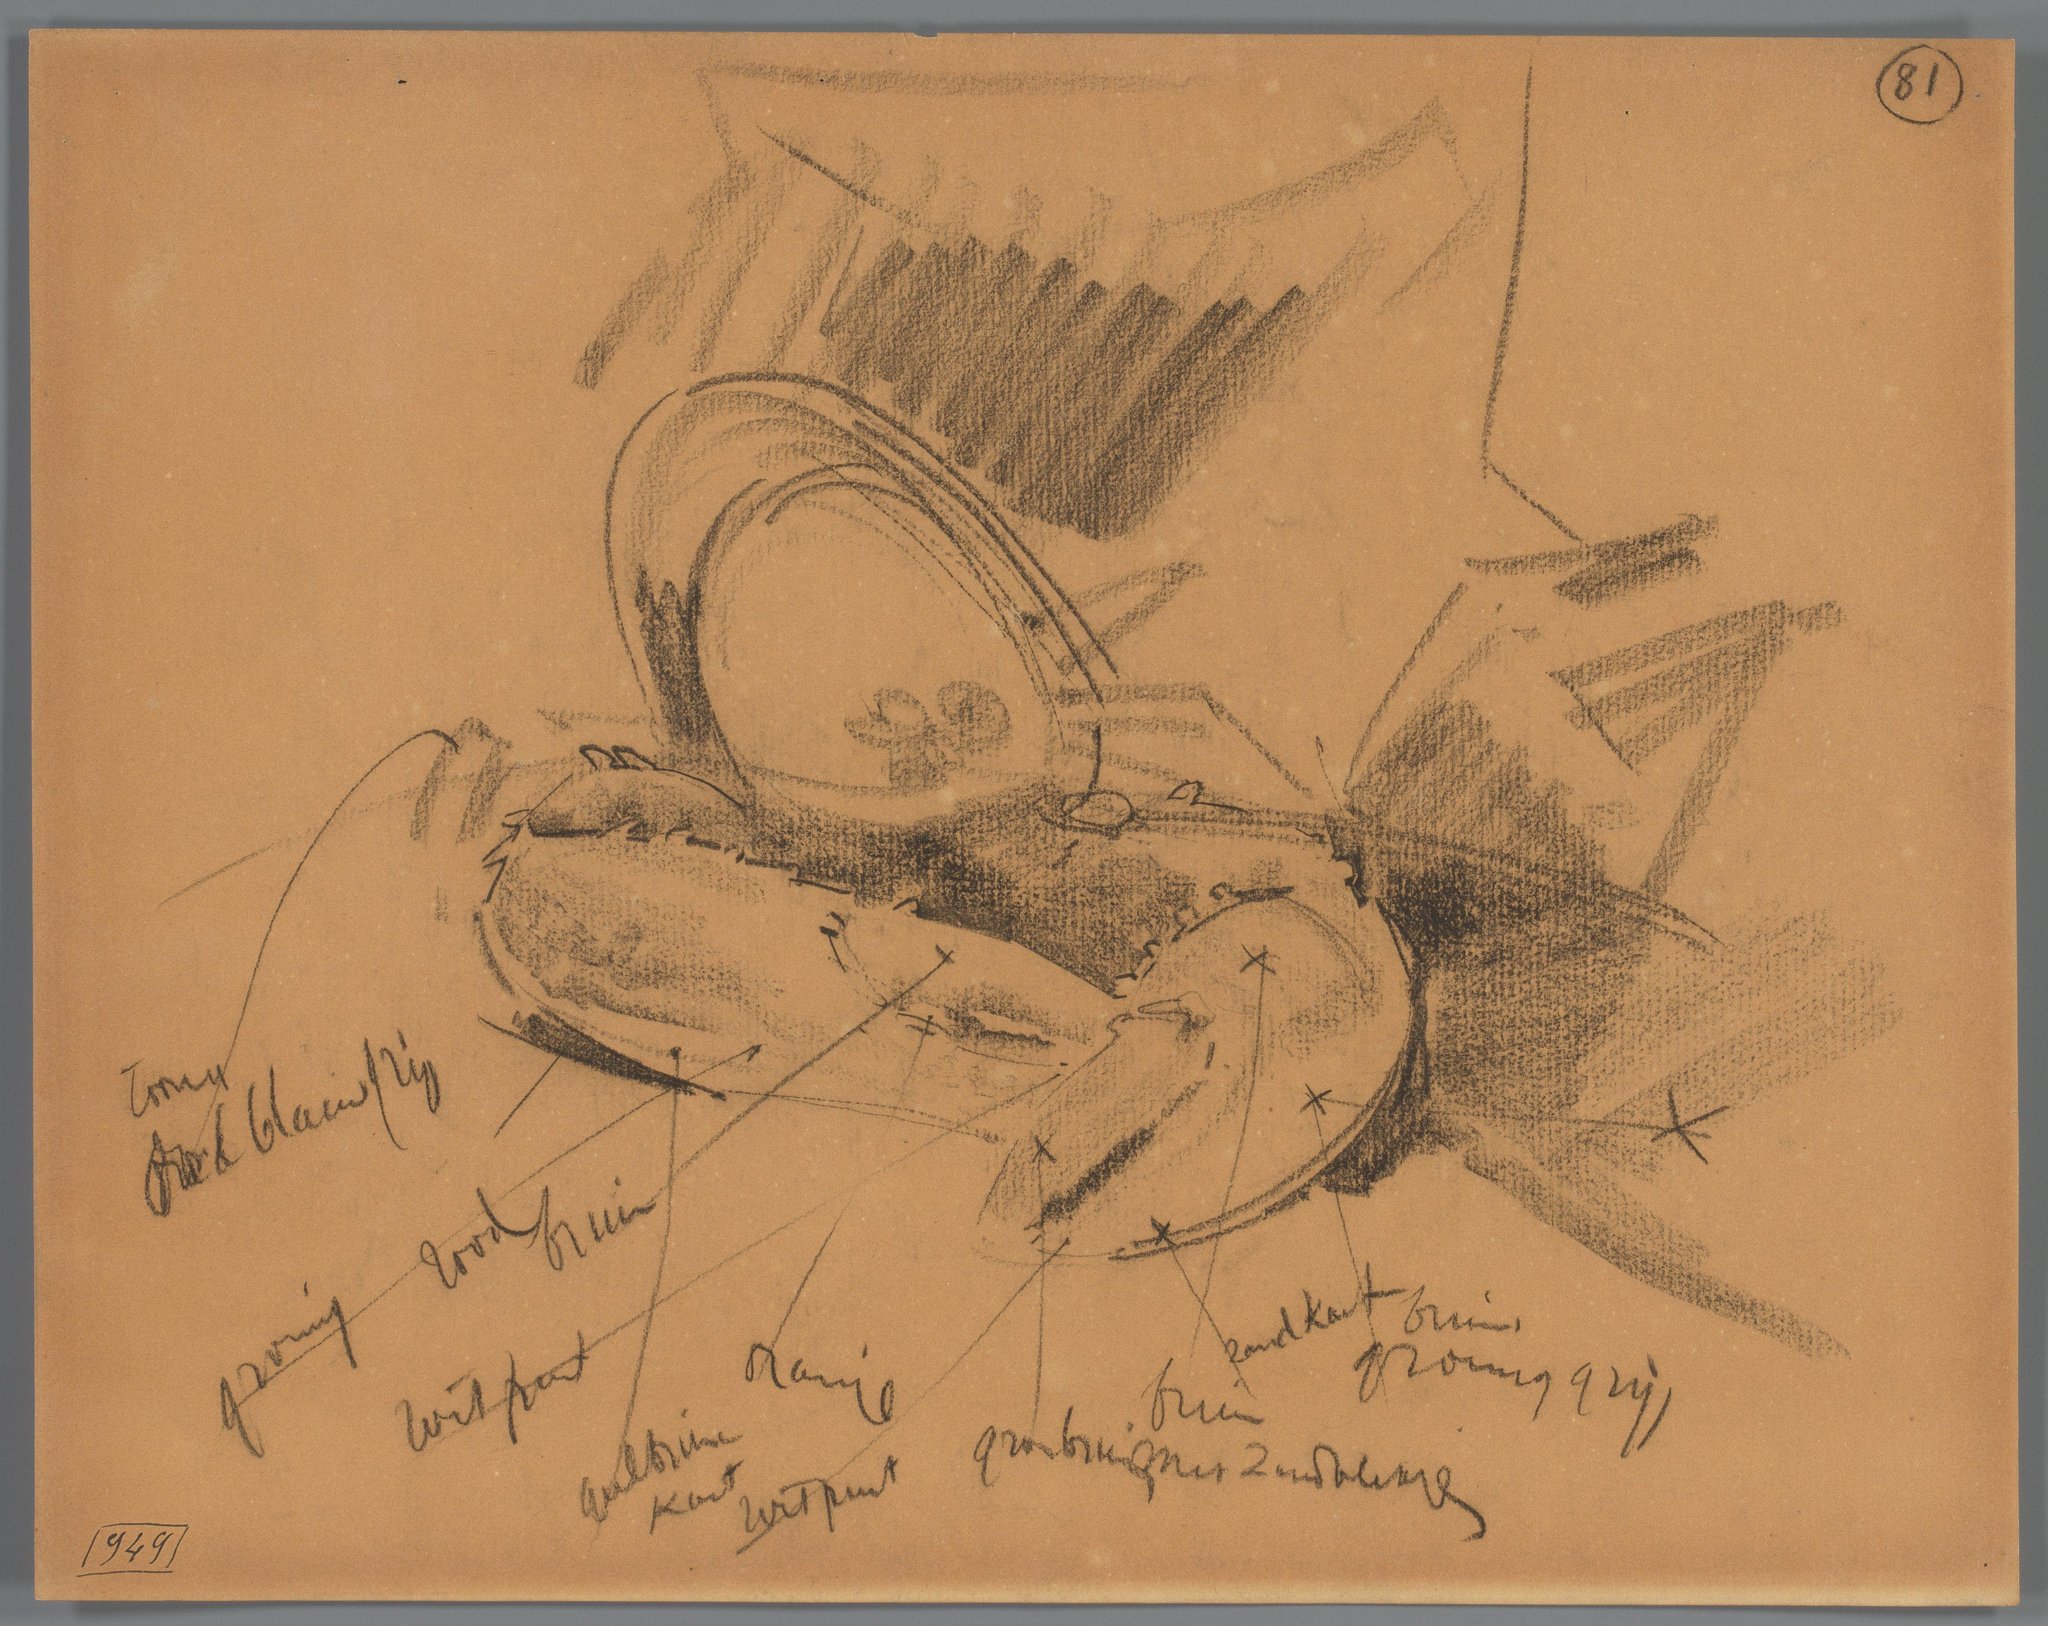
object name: drawing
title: Studie van de scharen van een kreeft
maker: gerrit willem dijsselhof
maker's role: designer, draughtsman, print maker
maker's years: 1866-1924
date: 1876-1924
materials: chalk, paper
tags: crustaceans: lobster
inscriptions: number: ‘81’, number: ‘949’